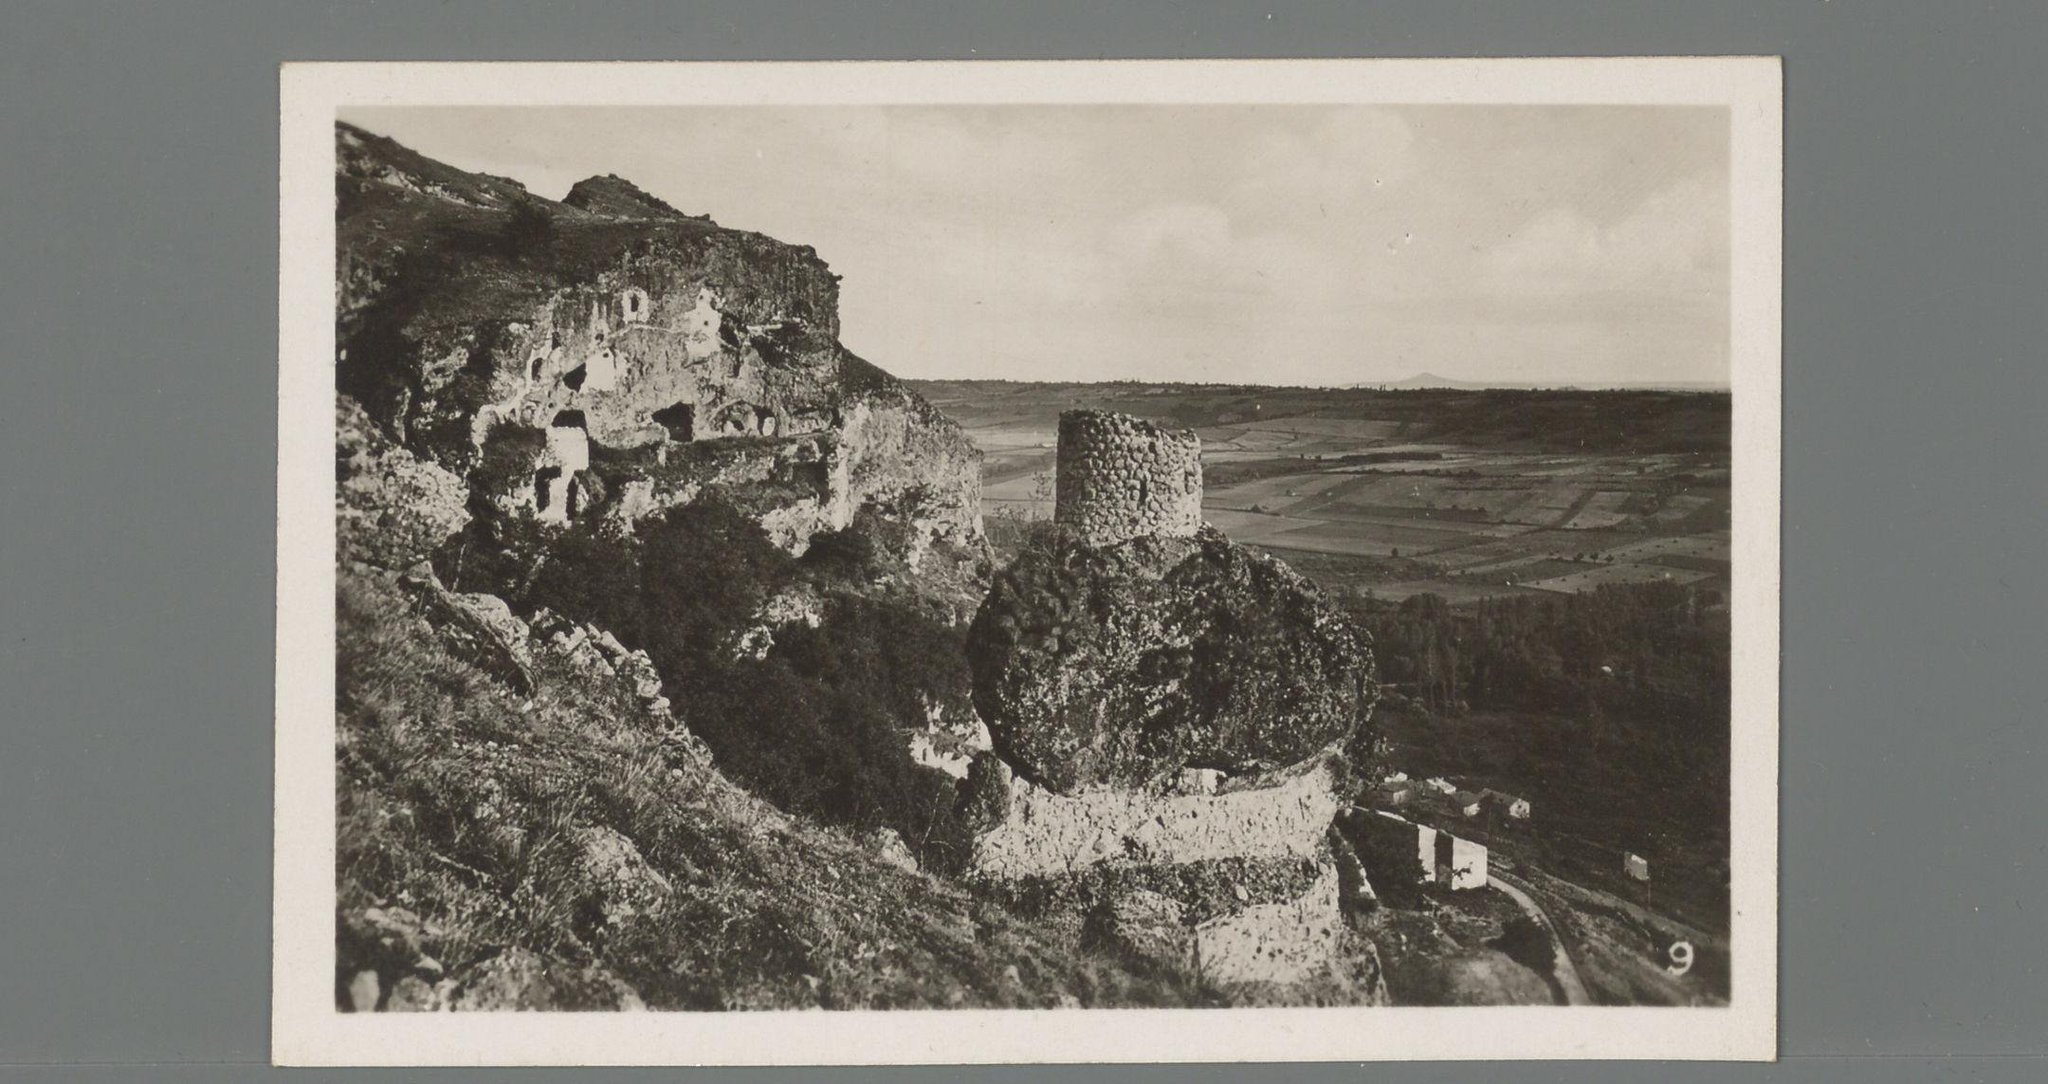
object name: photograph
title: L'Auvergne pittoresque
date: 1920-1932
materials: photographic support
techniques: photography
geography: auvergne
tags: castle, landscapes in the temperate zone